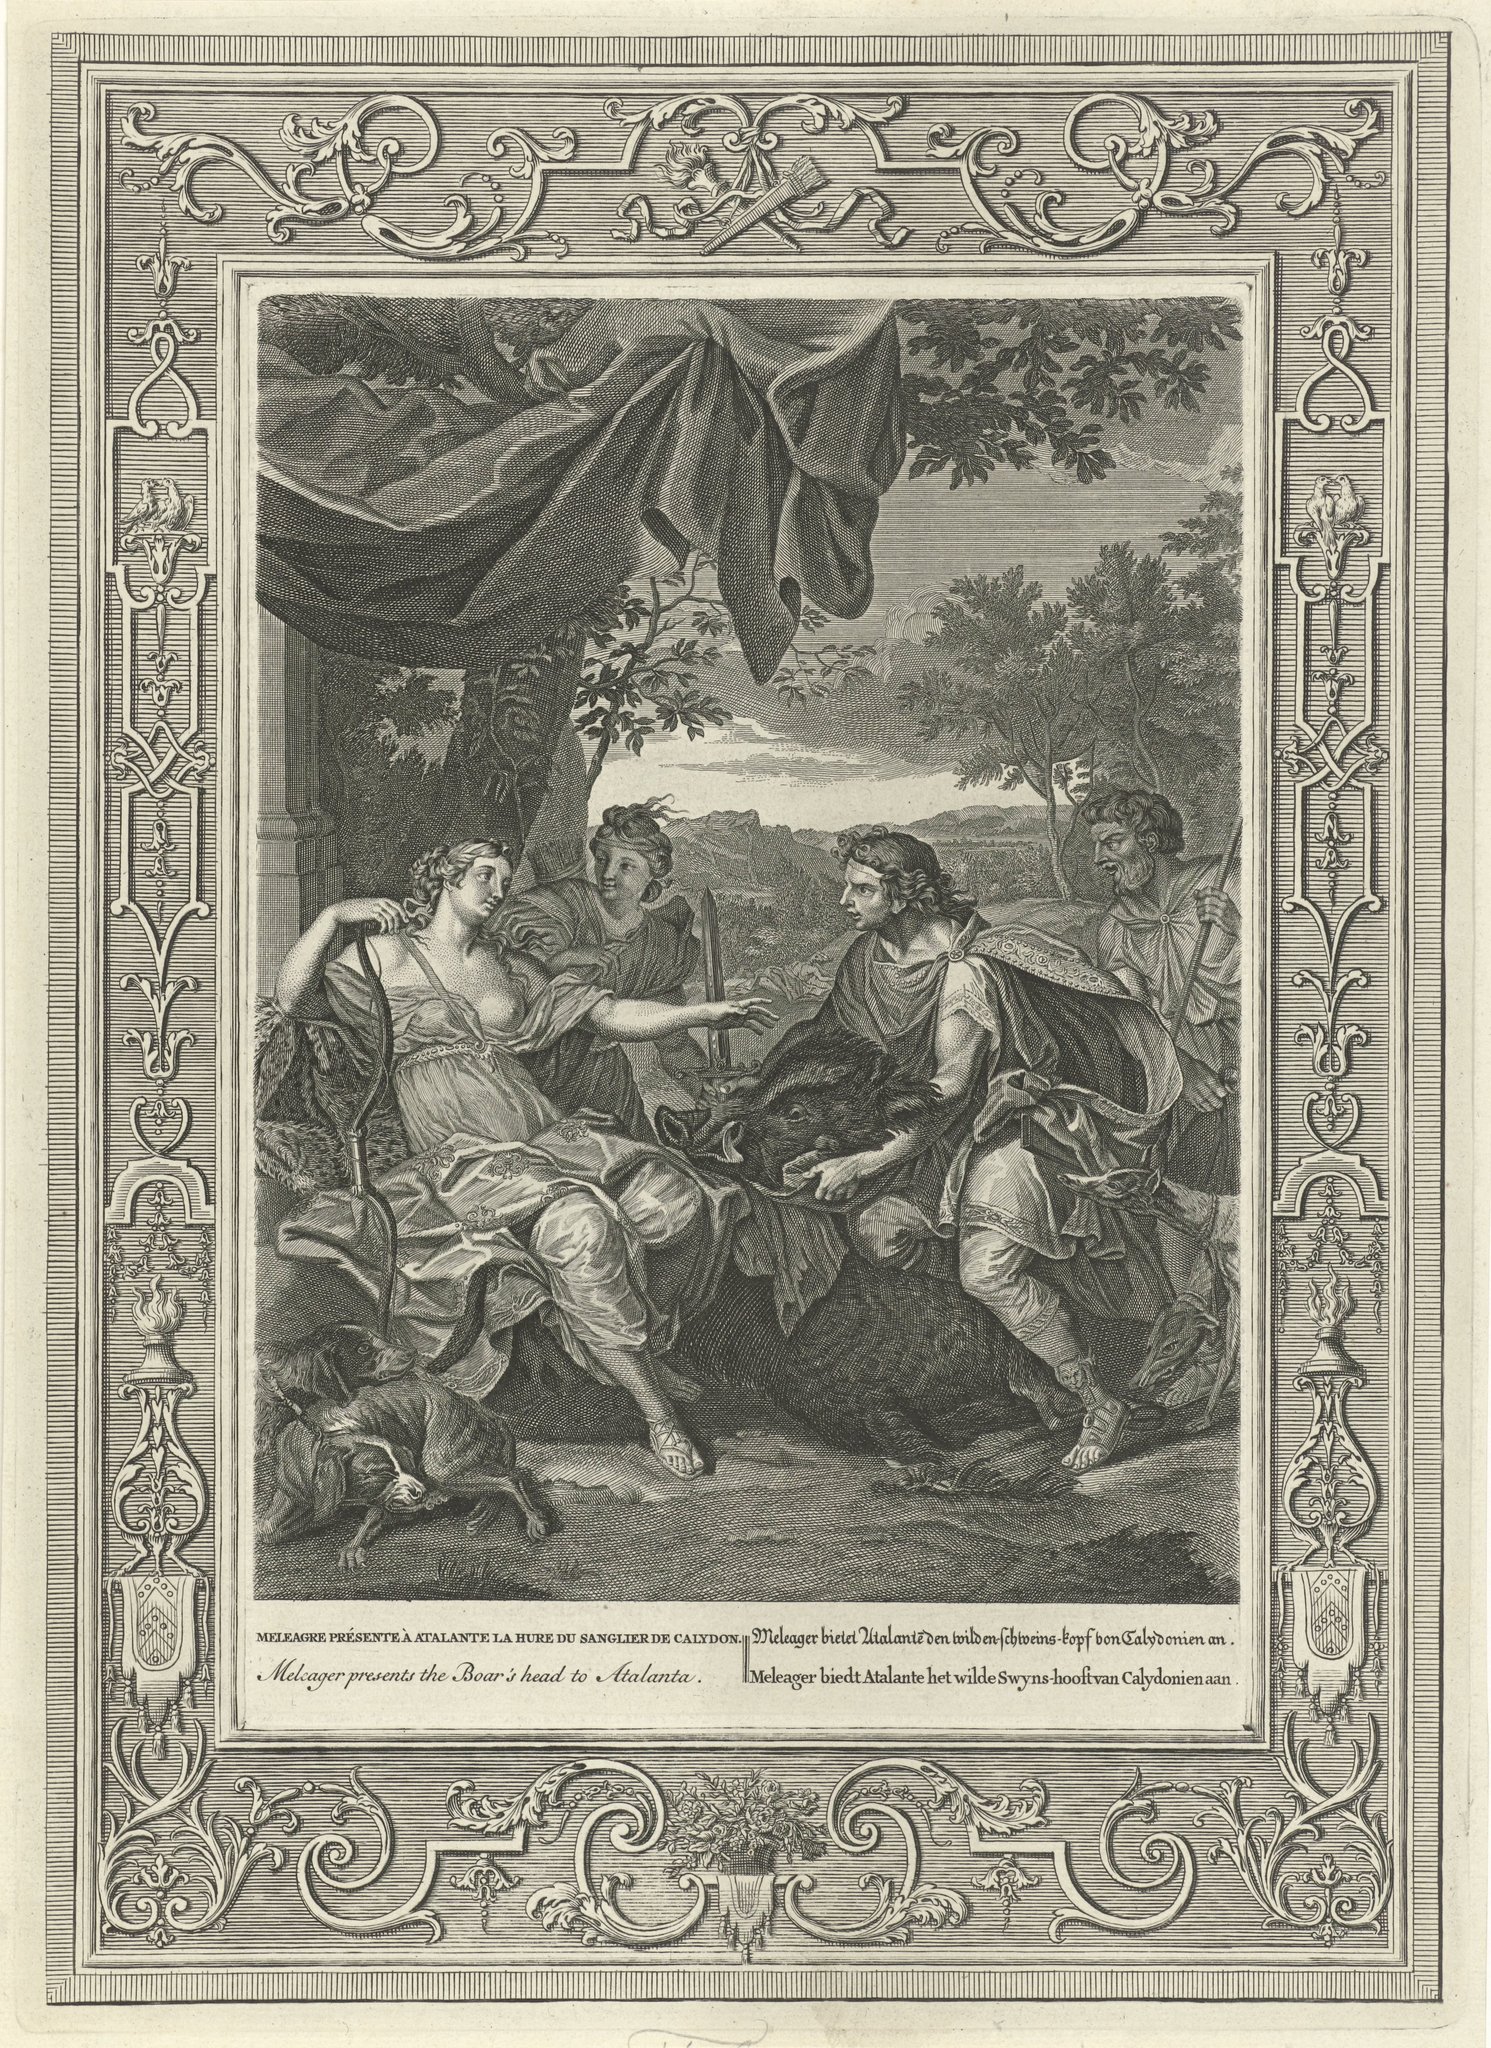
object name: print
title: Meleager en Atalanta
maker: bernard picart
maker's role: draughtsman, print maker, publisher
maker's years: 1673-1733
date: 1733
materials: paper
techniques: engraving, etching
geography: amsterdam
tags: scrollwork, strapwork ~ ornament, meleager gives the head of the boar to atalanta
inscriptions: collector's mark: Lugt 2228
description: Prent ook als illustratie gebruikt in: Beaumarchais, Antoine de La Barre de. Le Temple des Muses: orné de 60 tableaux où sont représentés les événemens les plus remarquables de l'antiquité fabuleuse. Amsterdam: Zacharias Chatelain (II), 1733.